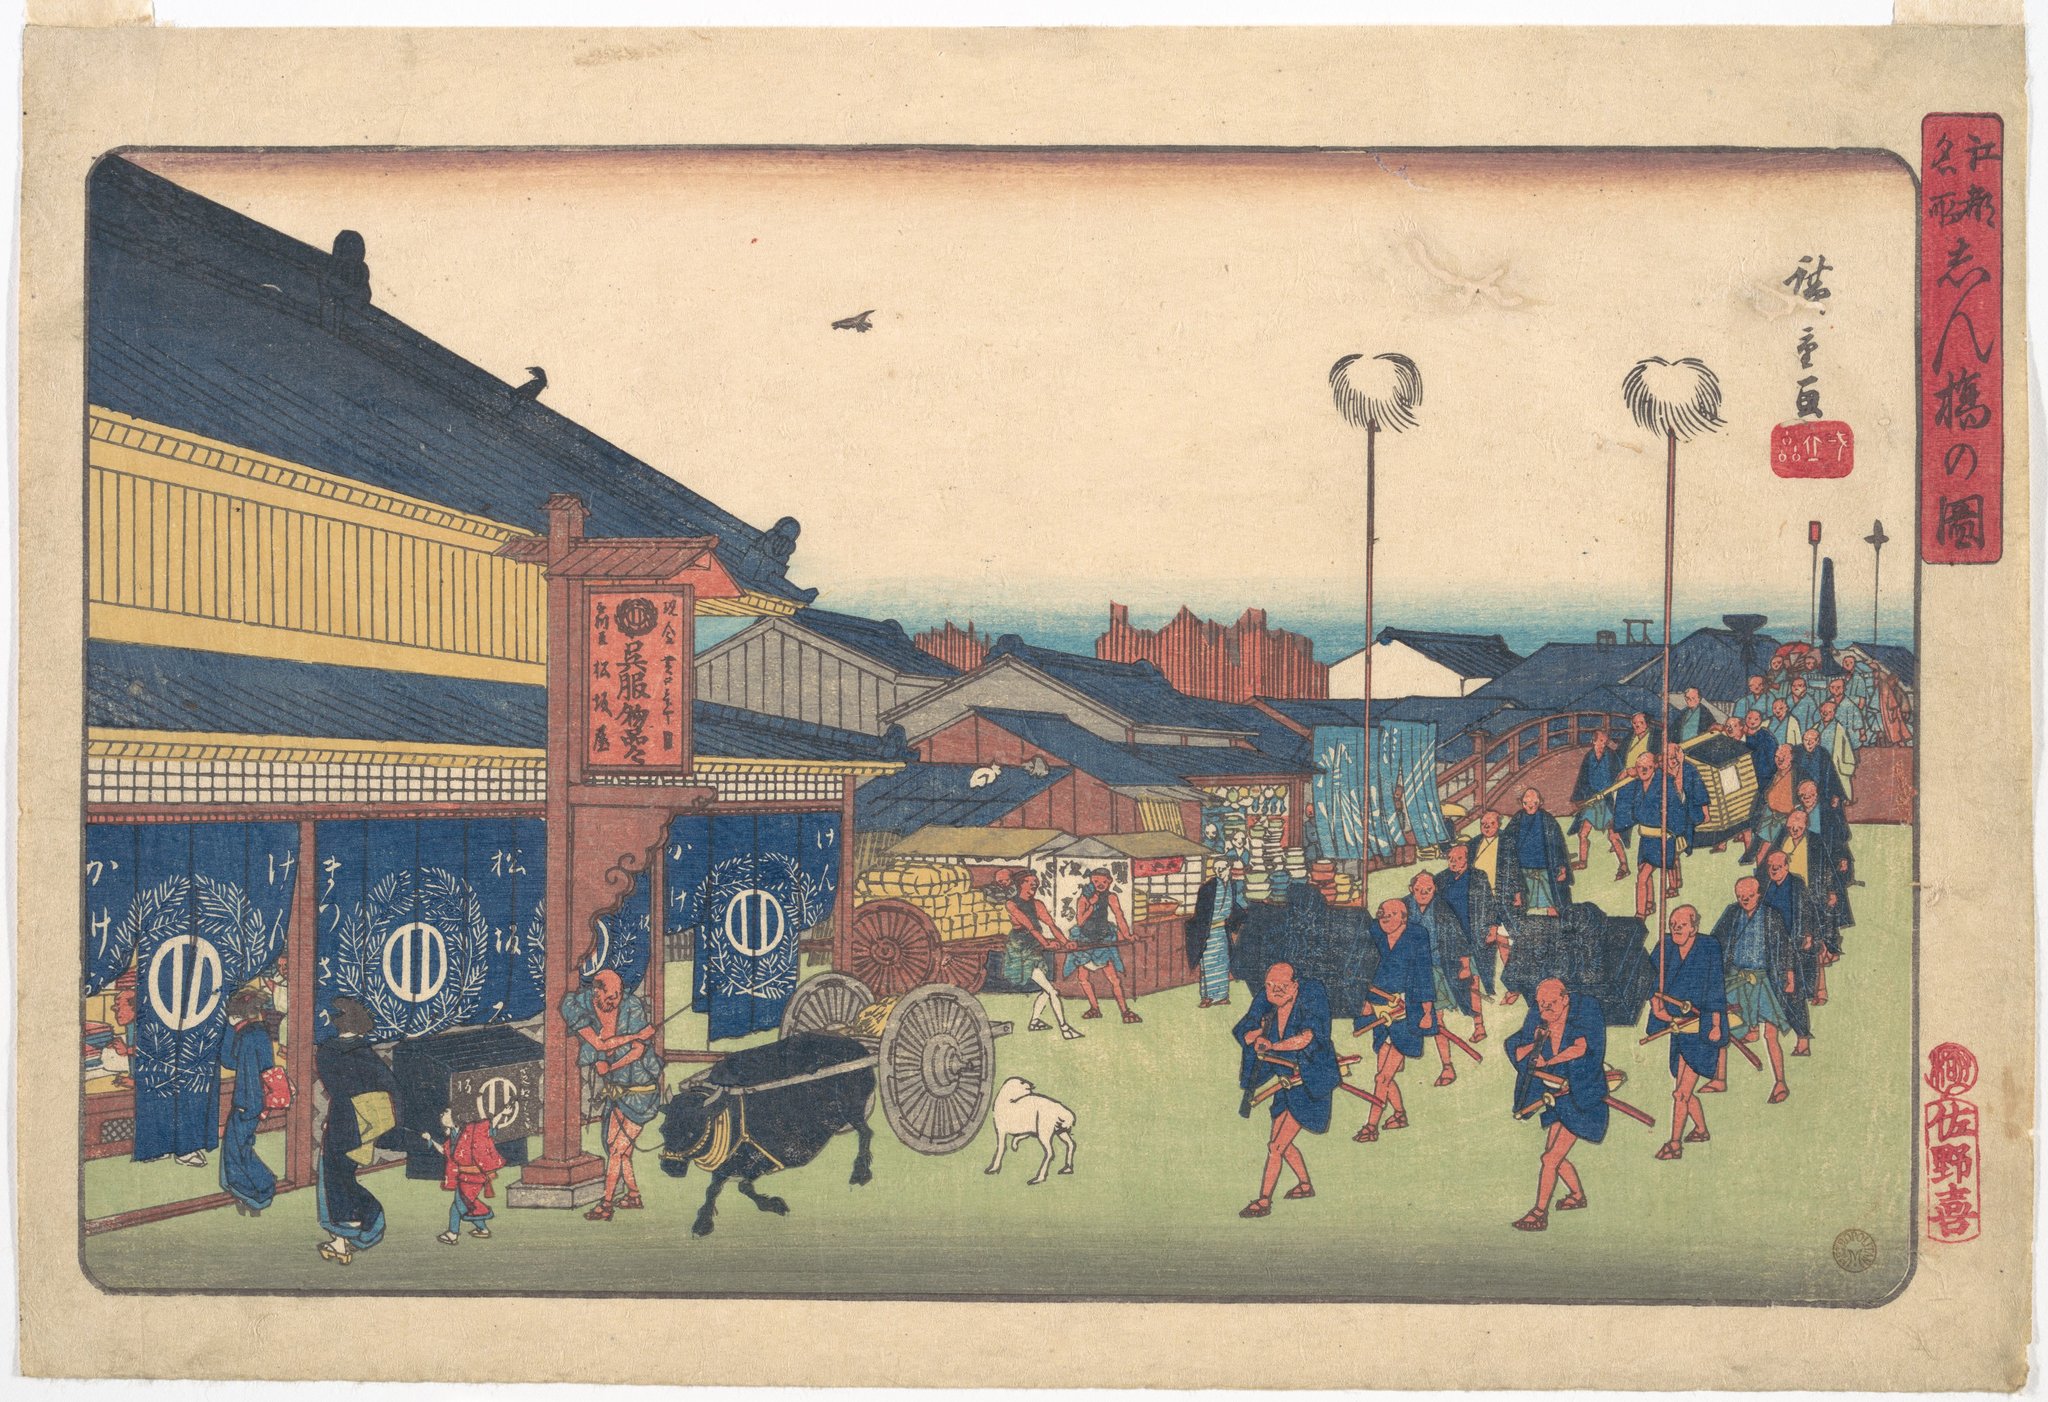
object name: print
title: Shimbashi no Zu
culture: japanese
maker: utagawa hiroshige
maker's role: artist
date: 1837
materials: ink, paper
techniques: woodblock print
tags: animals,buildings,men,crowd